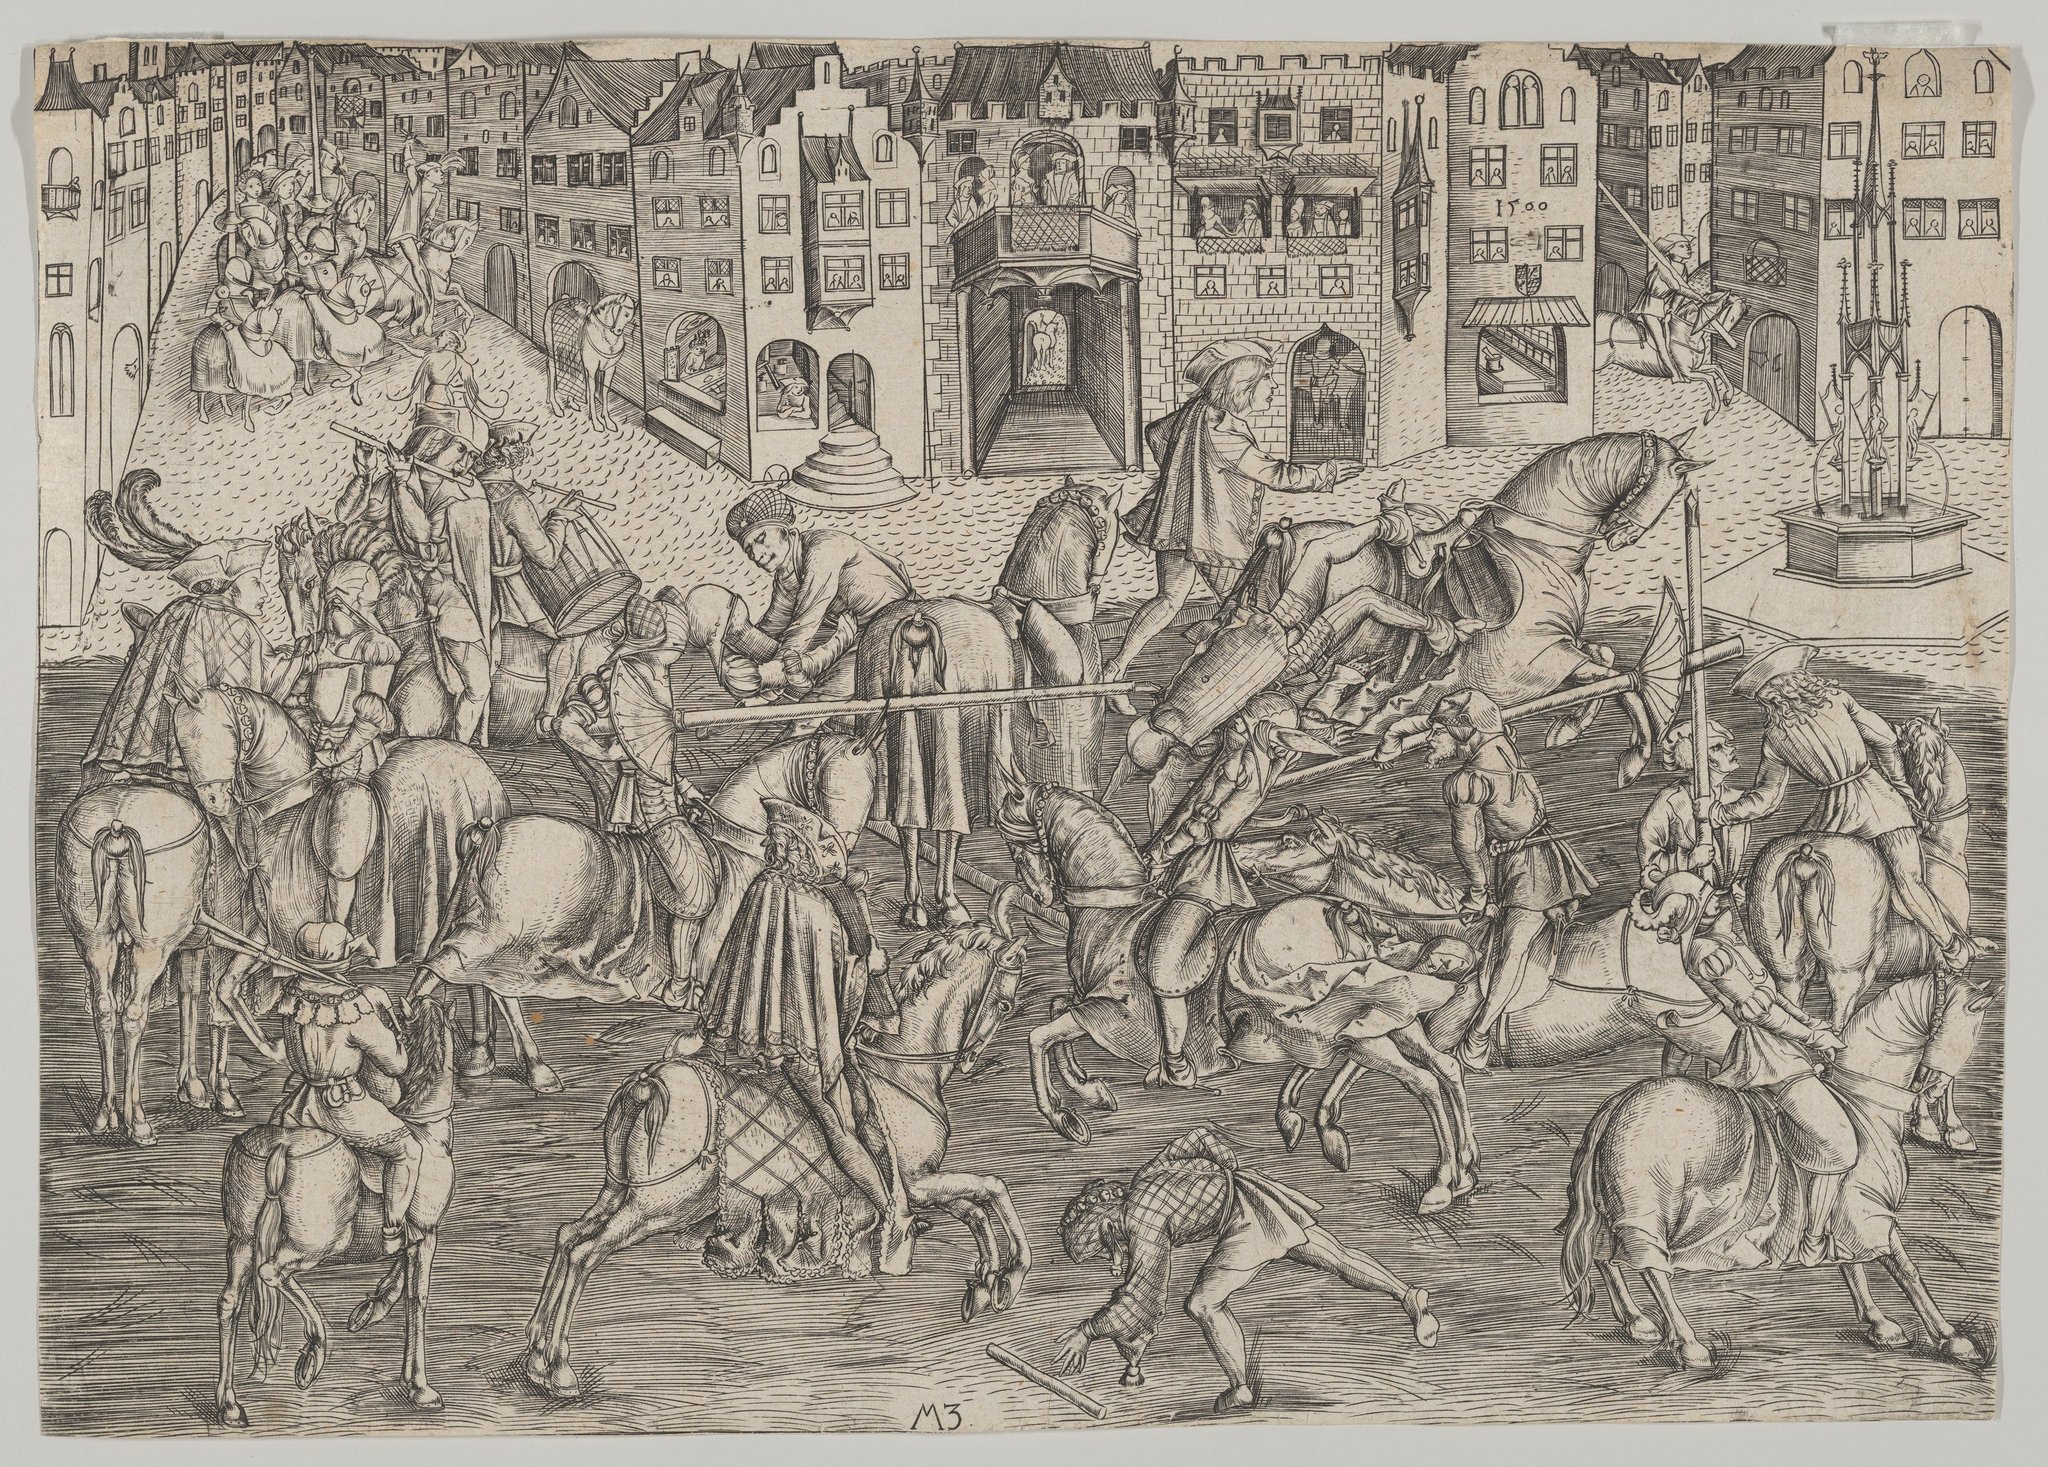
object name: print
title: The Tournament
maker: master mz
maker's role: artist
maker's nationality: german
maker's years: 1477-1525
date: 1500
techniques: engraving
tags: buildings,men,playing,horses